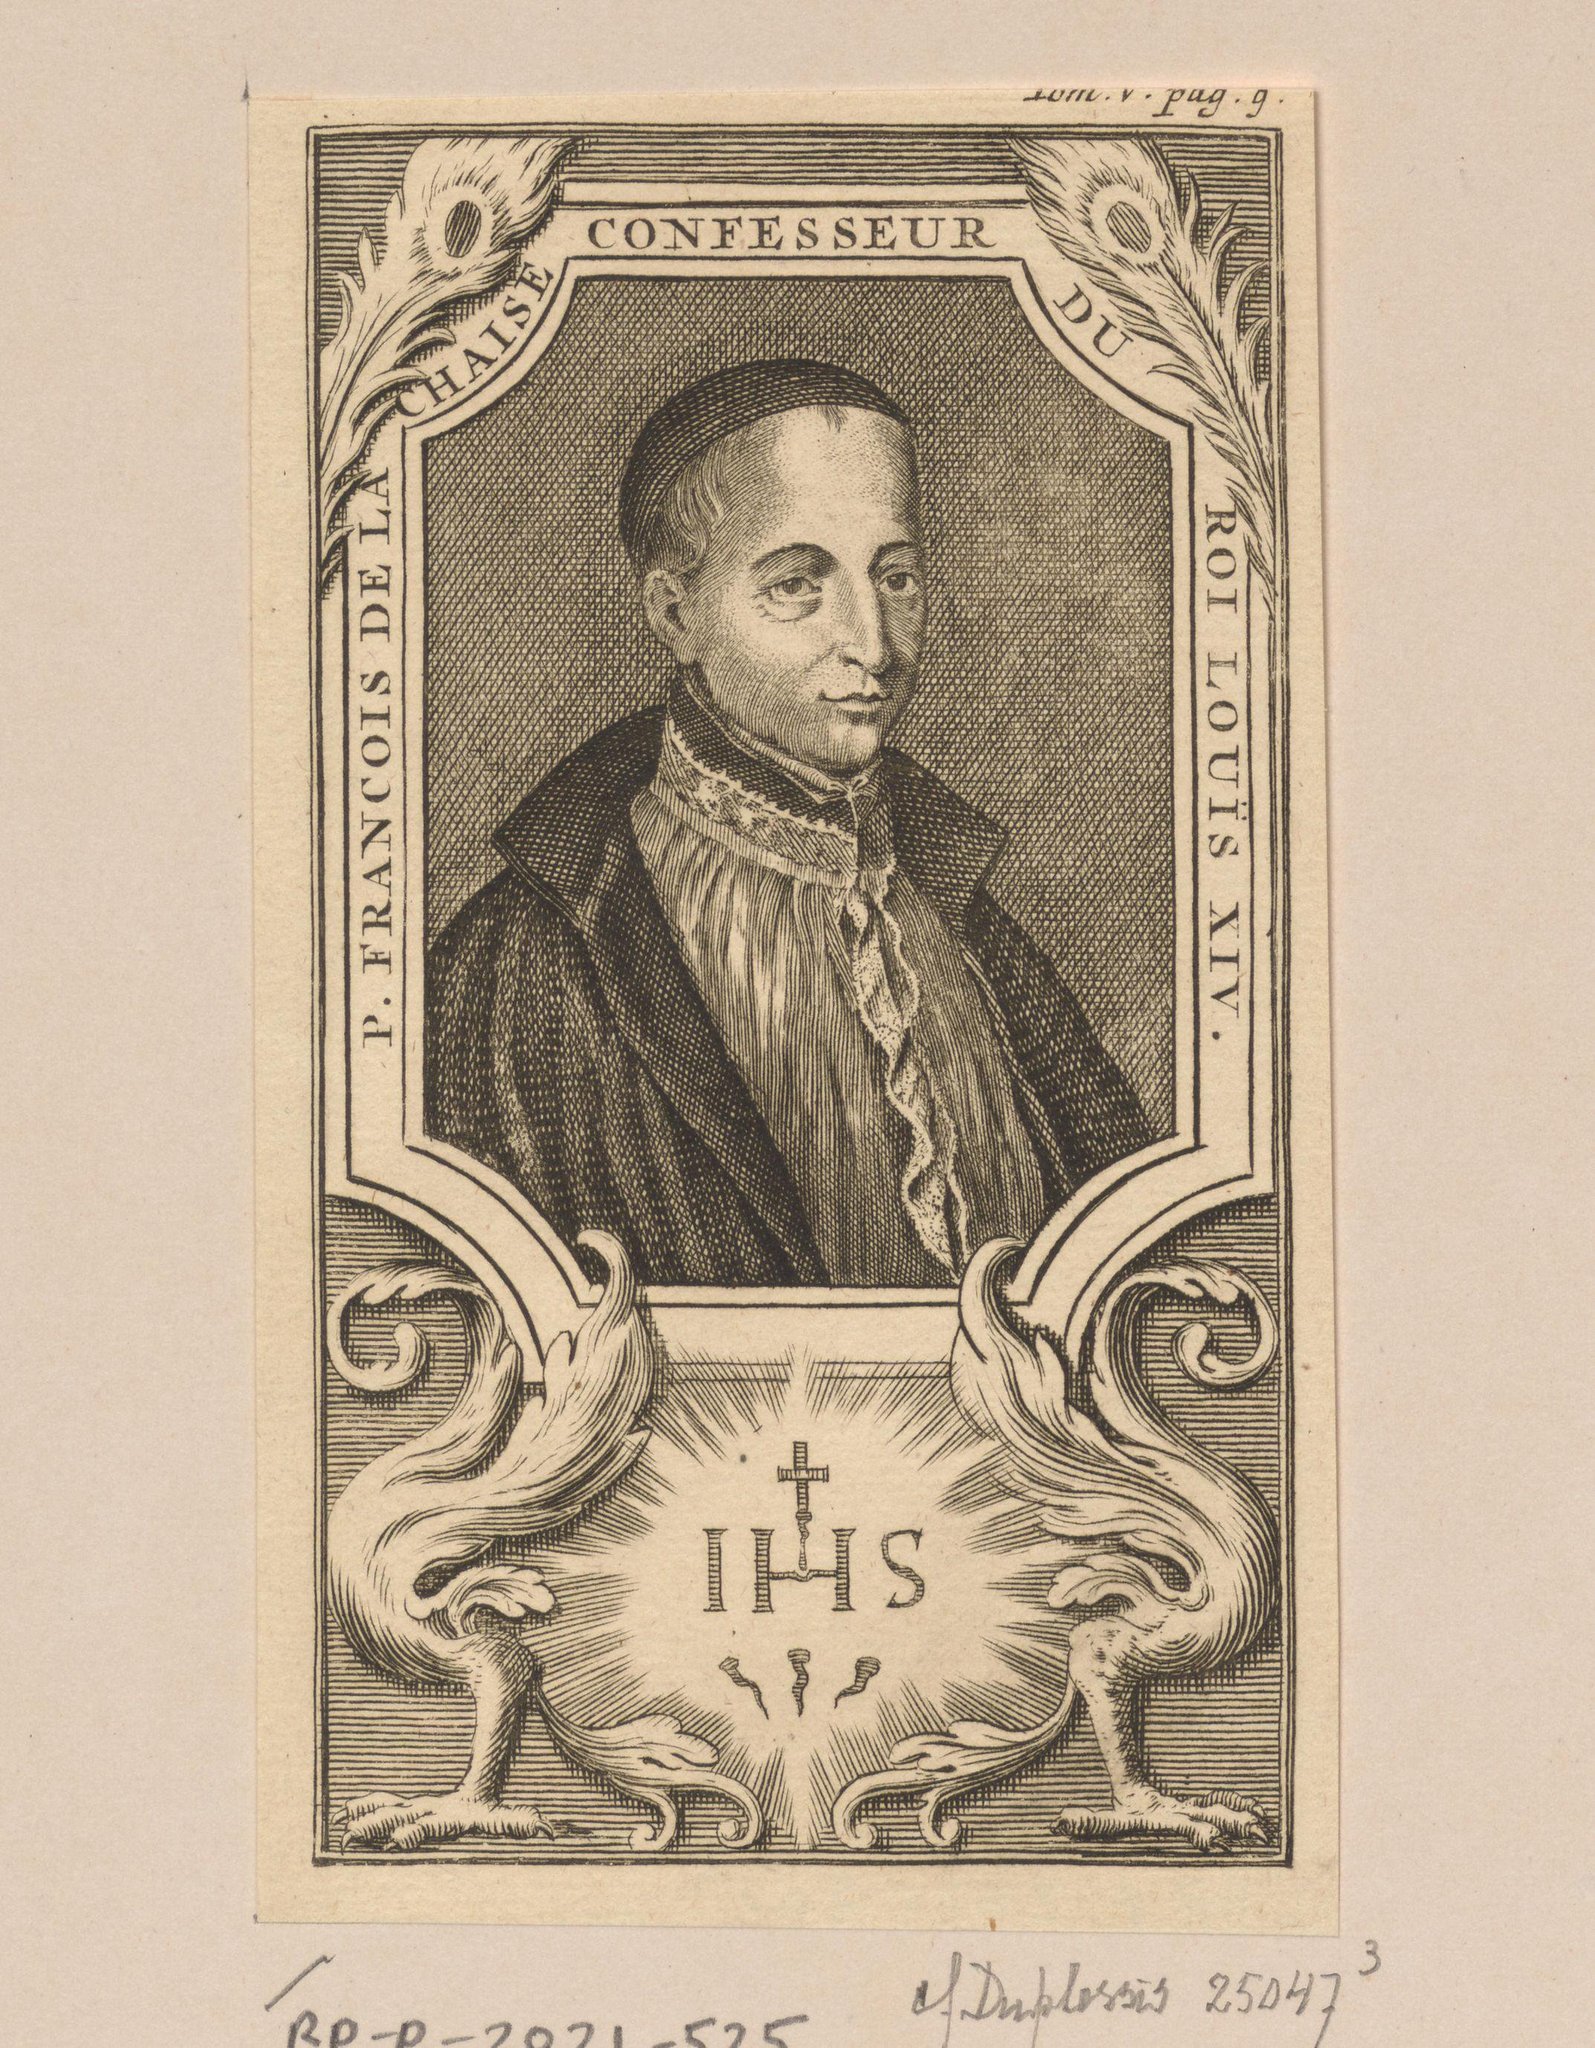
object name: book illustration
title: Portret van François de La Chaise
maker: Anonymous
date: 1674-1750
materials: paper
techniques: engraving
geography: france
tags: paris, clergyman, priest (roman catholic), historical persons, other ornament derived from animal forms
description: Met Franse tekst rondom het portret. Rechtsboven: Tom. v. pag. 9.